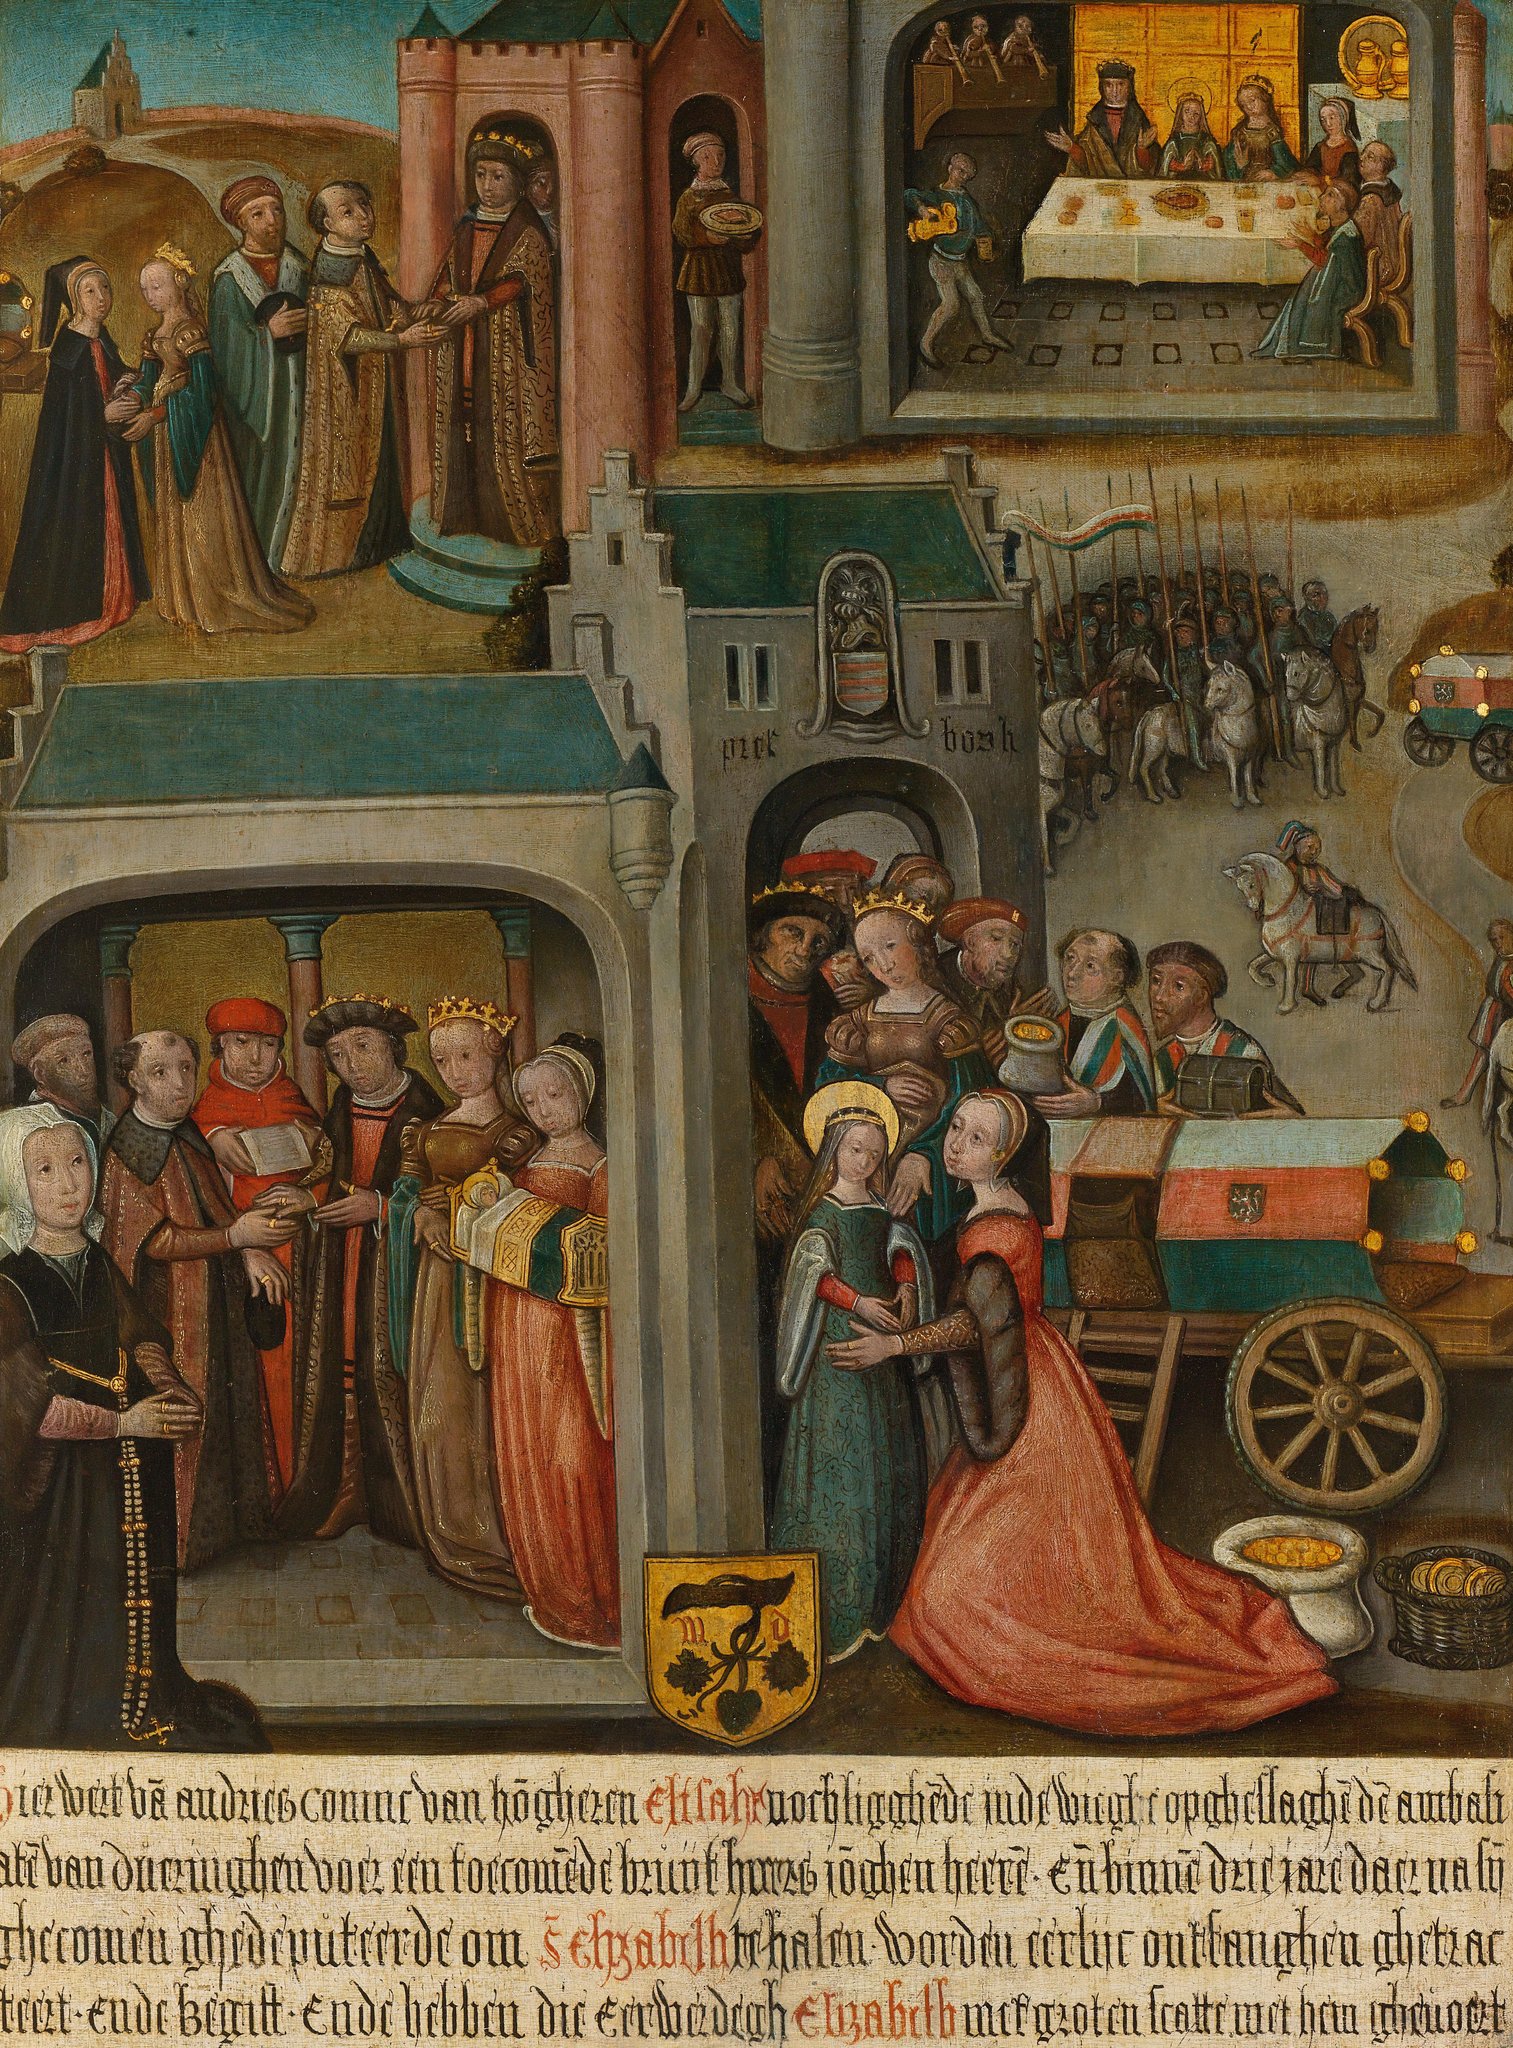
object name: painting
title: Four scenes from the legend of St Elizabeth of Hungary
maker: Anonymous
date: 1500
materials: oil, panel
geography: northern netherlands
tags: the wife and widow of the landgrave of thuringia, and franciscan tertiary, elisabeth of hungary; possible attributes: beggar, cripple, fish, loaves, leper, model of church, pitcher, roses in lap, scald-head, three crowns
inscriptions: coat of arms, centre bottom: twig with a descending stem supporting two flowers and a heart, all in brown, flanked by the letters m d in red, on a gold field, inscription, centre, on the gatehouse: Pres bor[c?]h, inscription, below the scene: ‘hier wert va[n] andries coninc van ho[n]gheren Elisah noch ligghe[n]de inde wieghe opgheslaghe[n] de[n] ambasiate[n] van dueringhen voer een toecome[n]de bruijt haers jo[n]ghen heere[n]. En[de] binne[n] drie jare daer na sij ghecomen ghedeputeerde om S[int] Elizabeth te halen. Worden eerlijc ontfangen ghetracteert. Ende begift. Ende hebben die Eerwerdegh Elizabeth met groten scatte met hen ghevoert.’, coat of arms, lower right, on the carriage: a lion rampant on a blue field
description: Vier taferelen uit de legende van de heilige Elisabeth van Hongarije. Scènes van een afscheid of ontmoeting bij een poort, een feestmaal met muzikanten, haar huwelijk met Lodewijk IV, landgraaf van Thüringen. Rechtsonder neemt de heilige Elisabeth afscheid van een vrouw (haar moeder?) bij de stadspoort van Presburg, waarna zij in een reiswagen vertrekt. Linksonderaan een knielende stichteres met een rozenkrans.